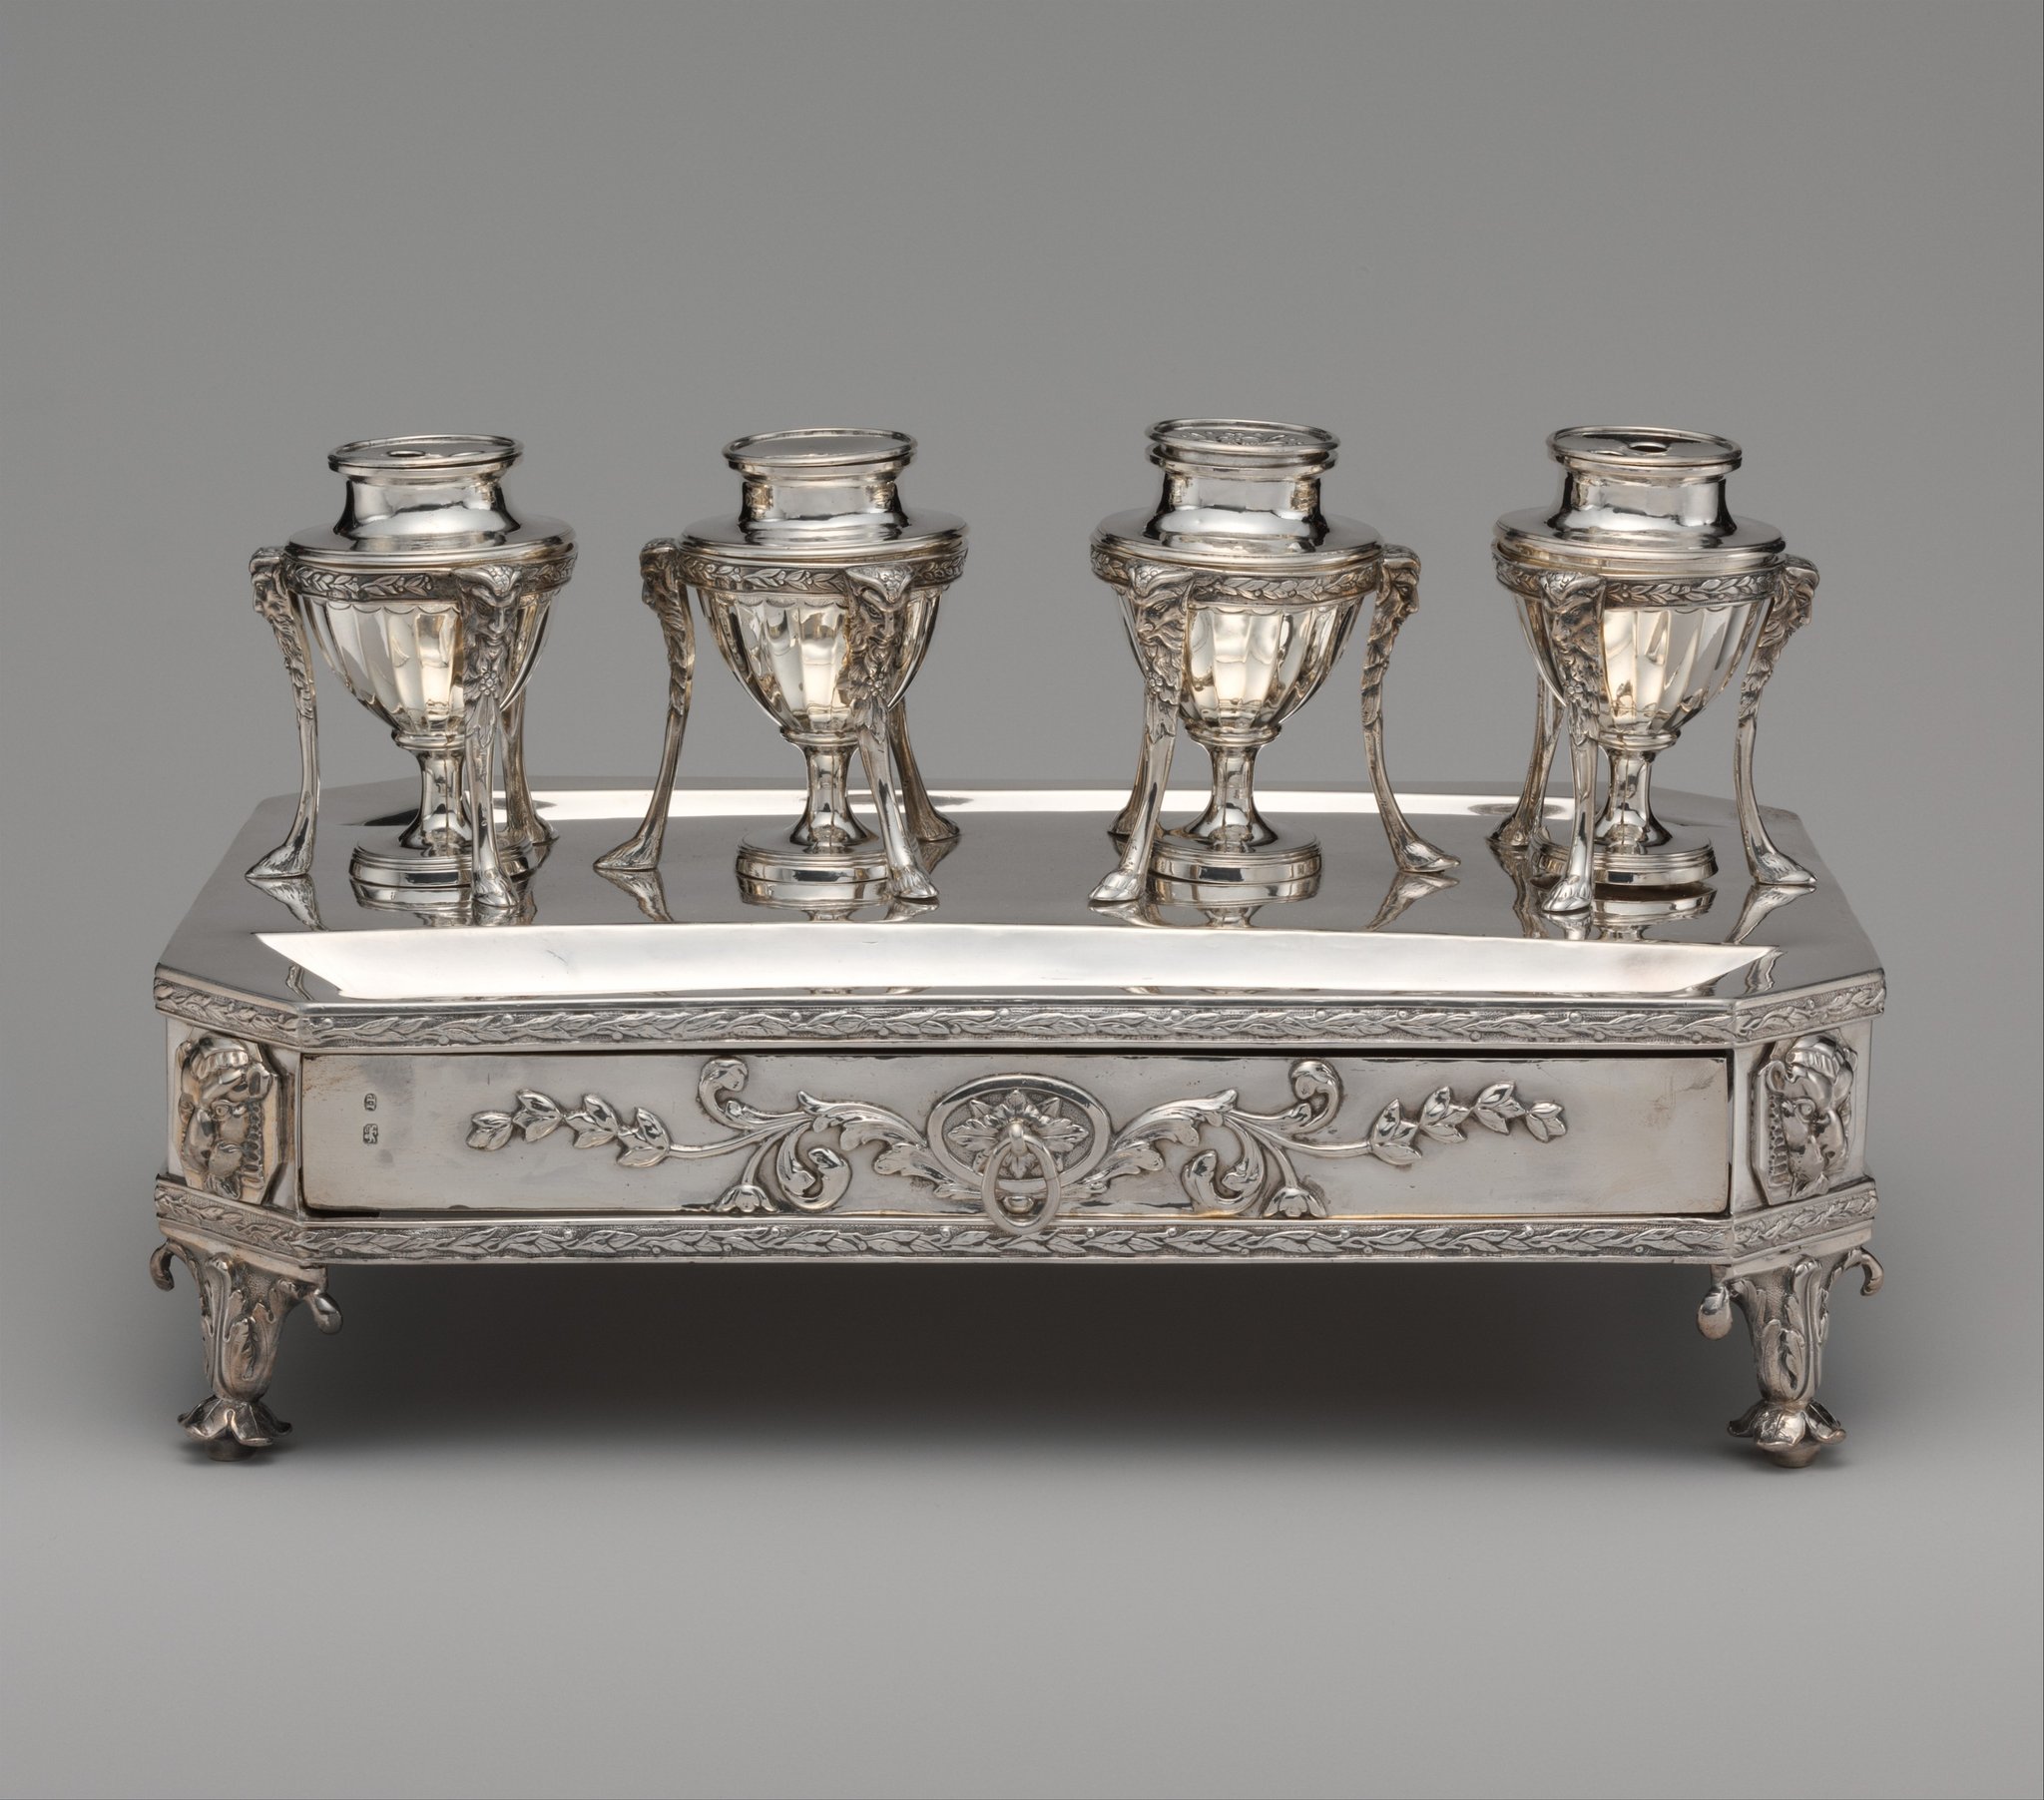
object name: inkstand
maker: john plimmer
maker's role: maker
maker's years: 1771-1803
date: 1802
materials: silver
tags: satyrs,lions